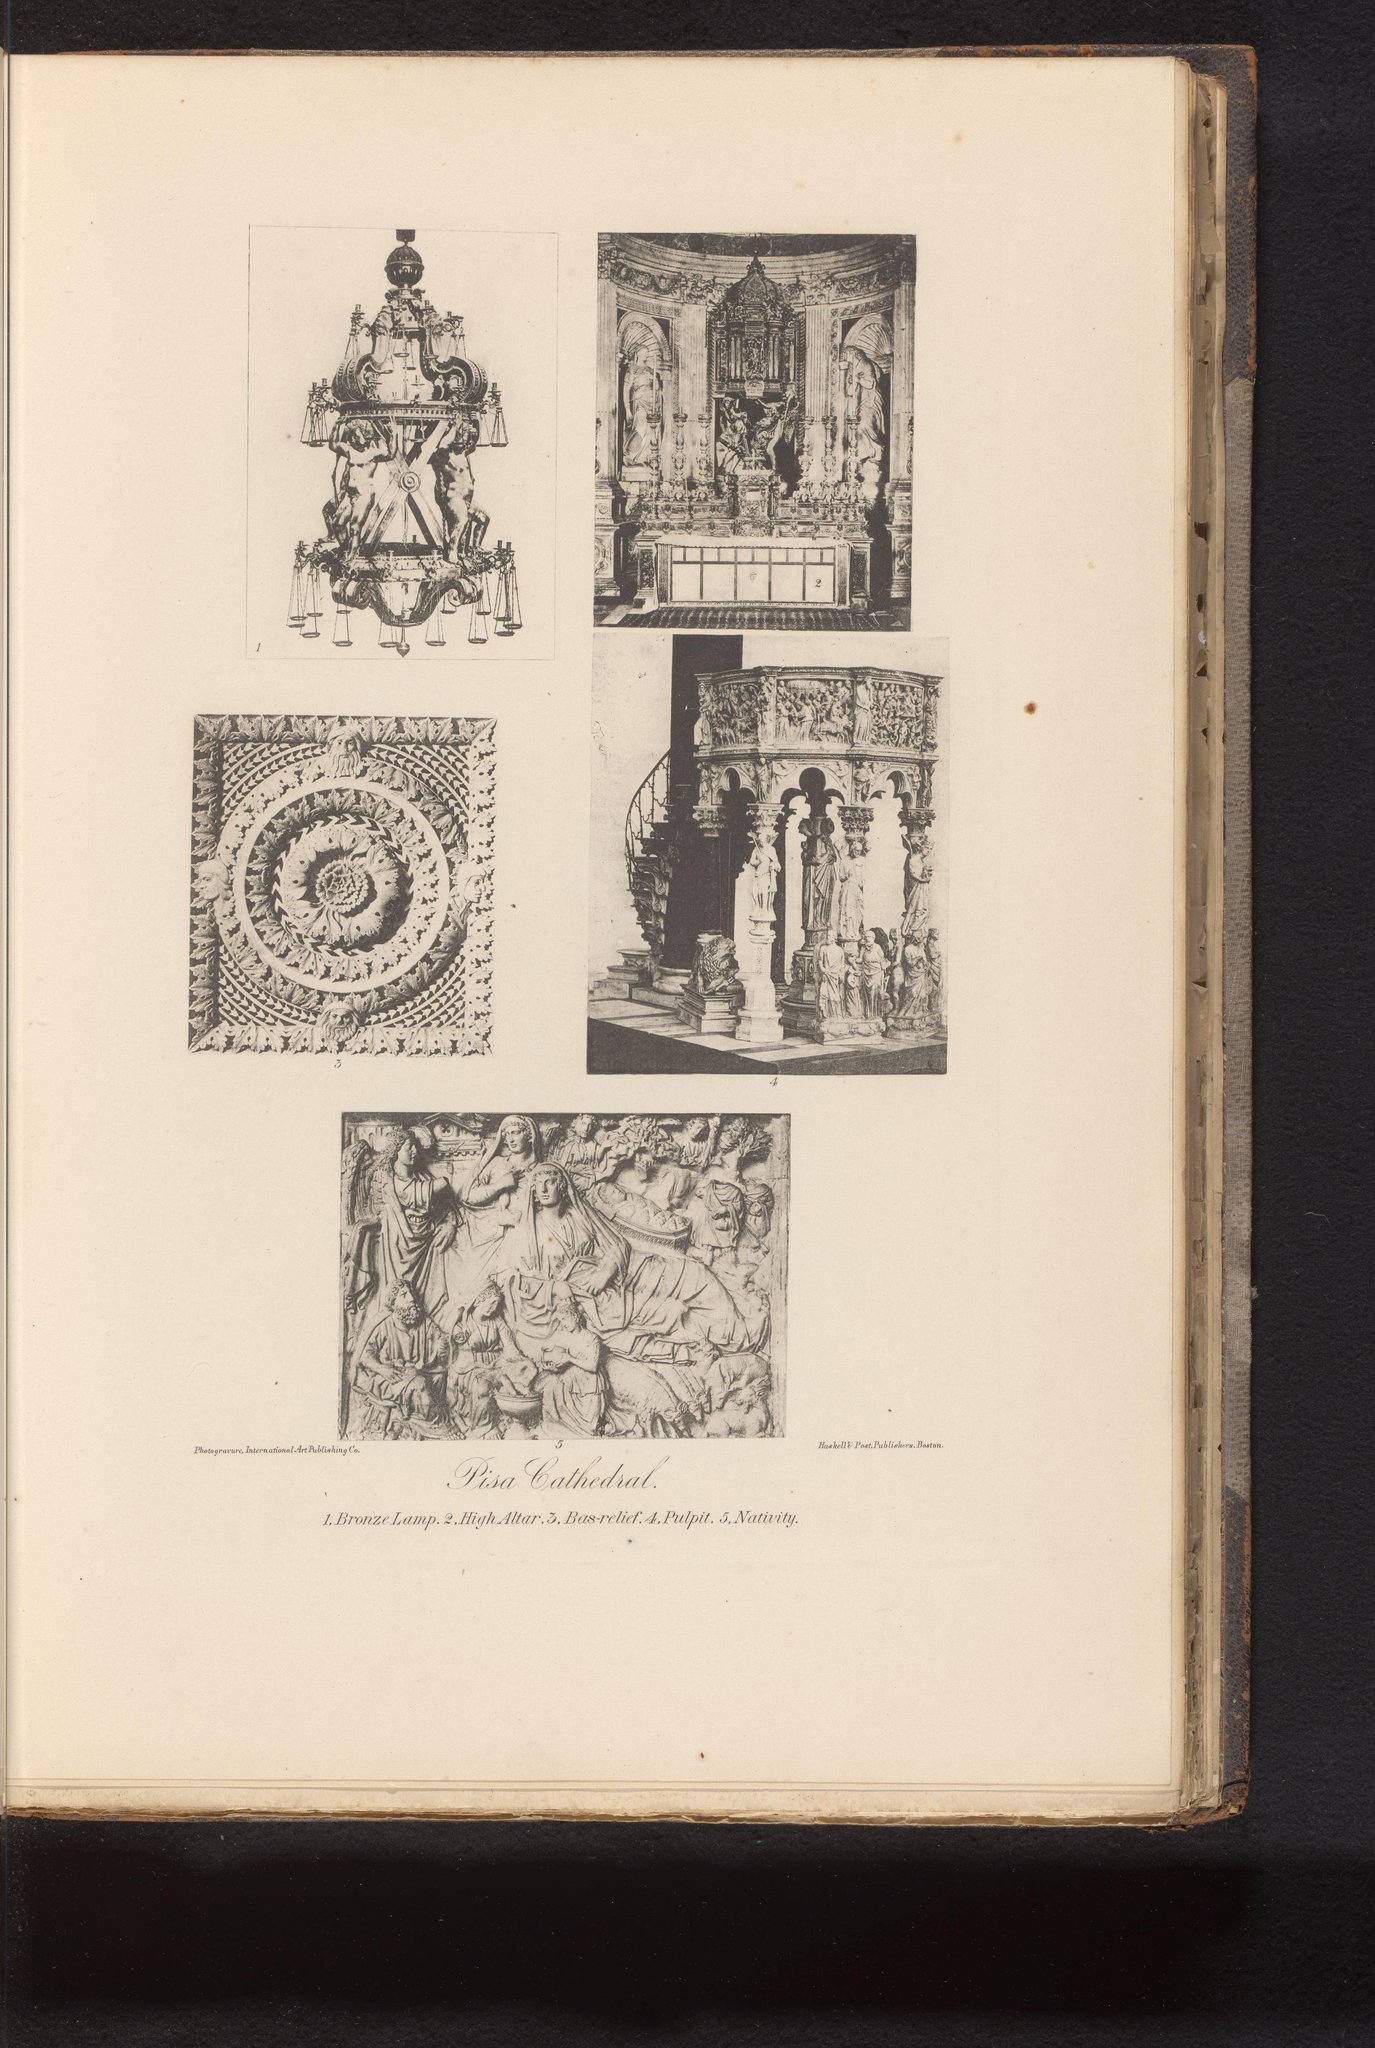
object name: photomechanical print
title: Pisa Cathedral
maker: Anonymous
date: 1881-1886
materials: paper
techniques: photograph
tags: nativity scene ~ equipment of church, interior of church, pulpit, ambo, chancel, altar, sculpture (+ relief ~ sculpture)